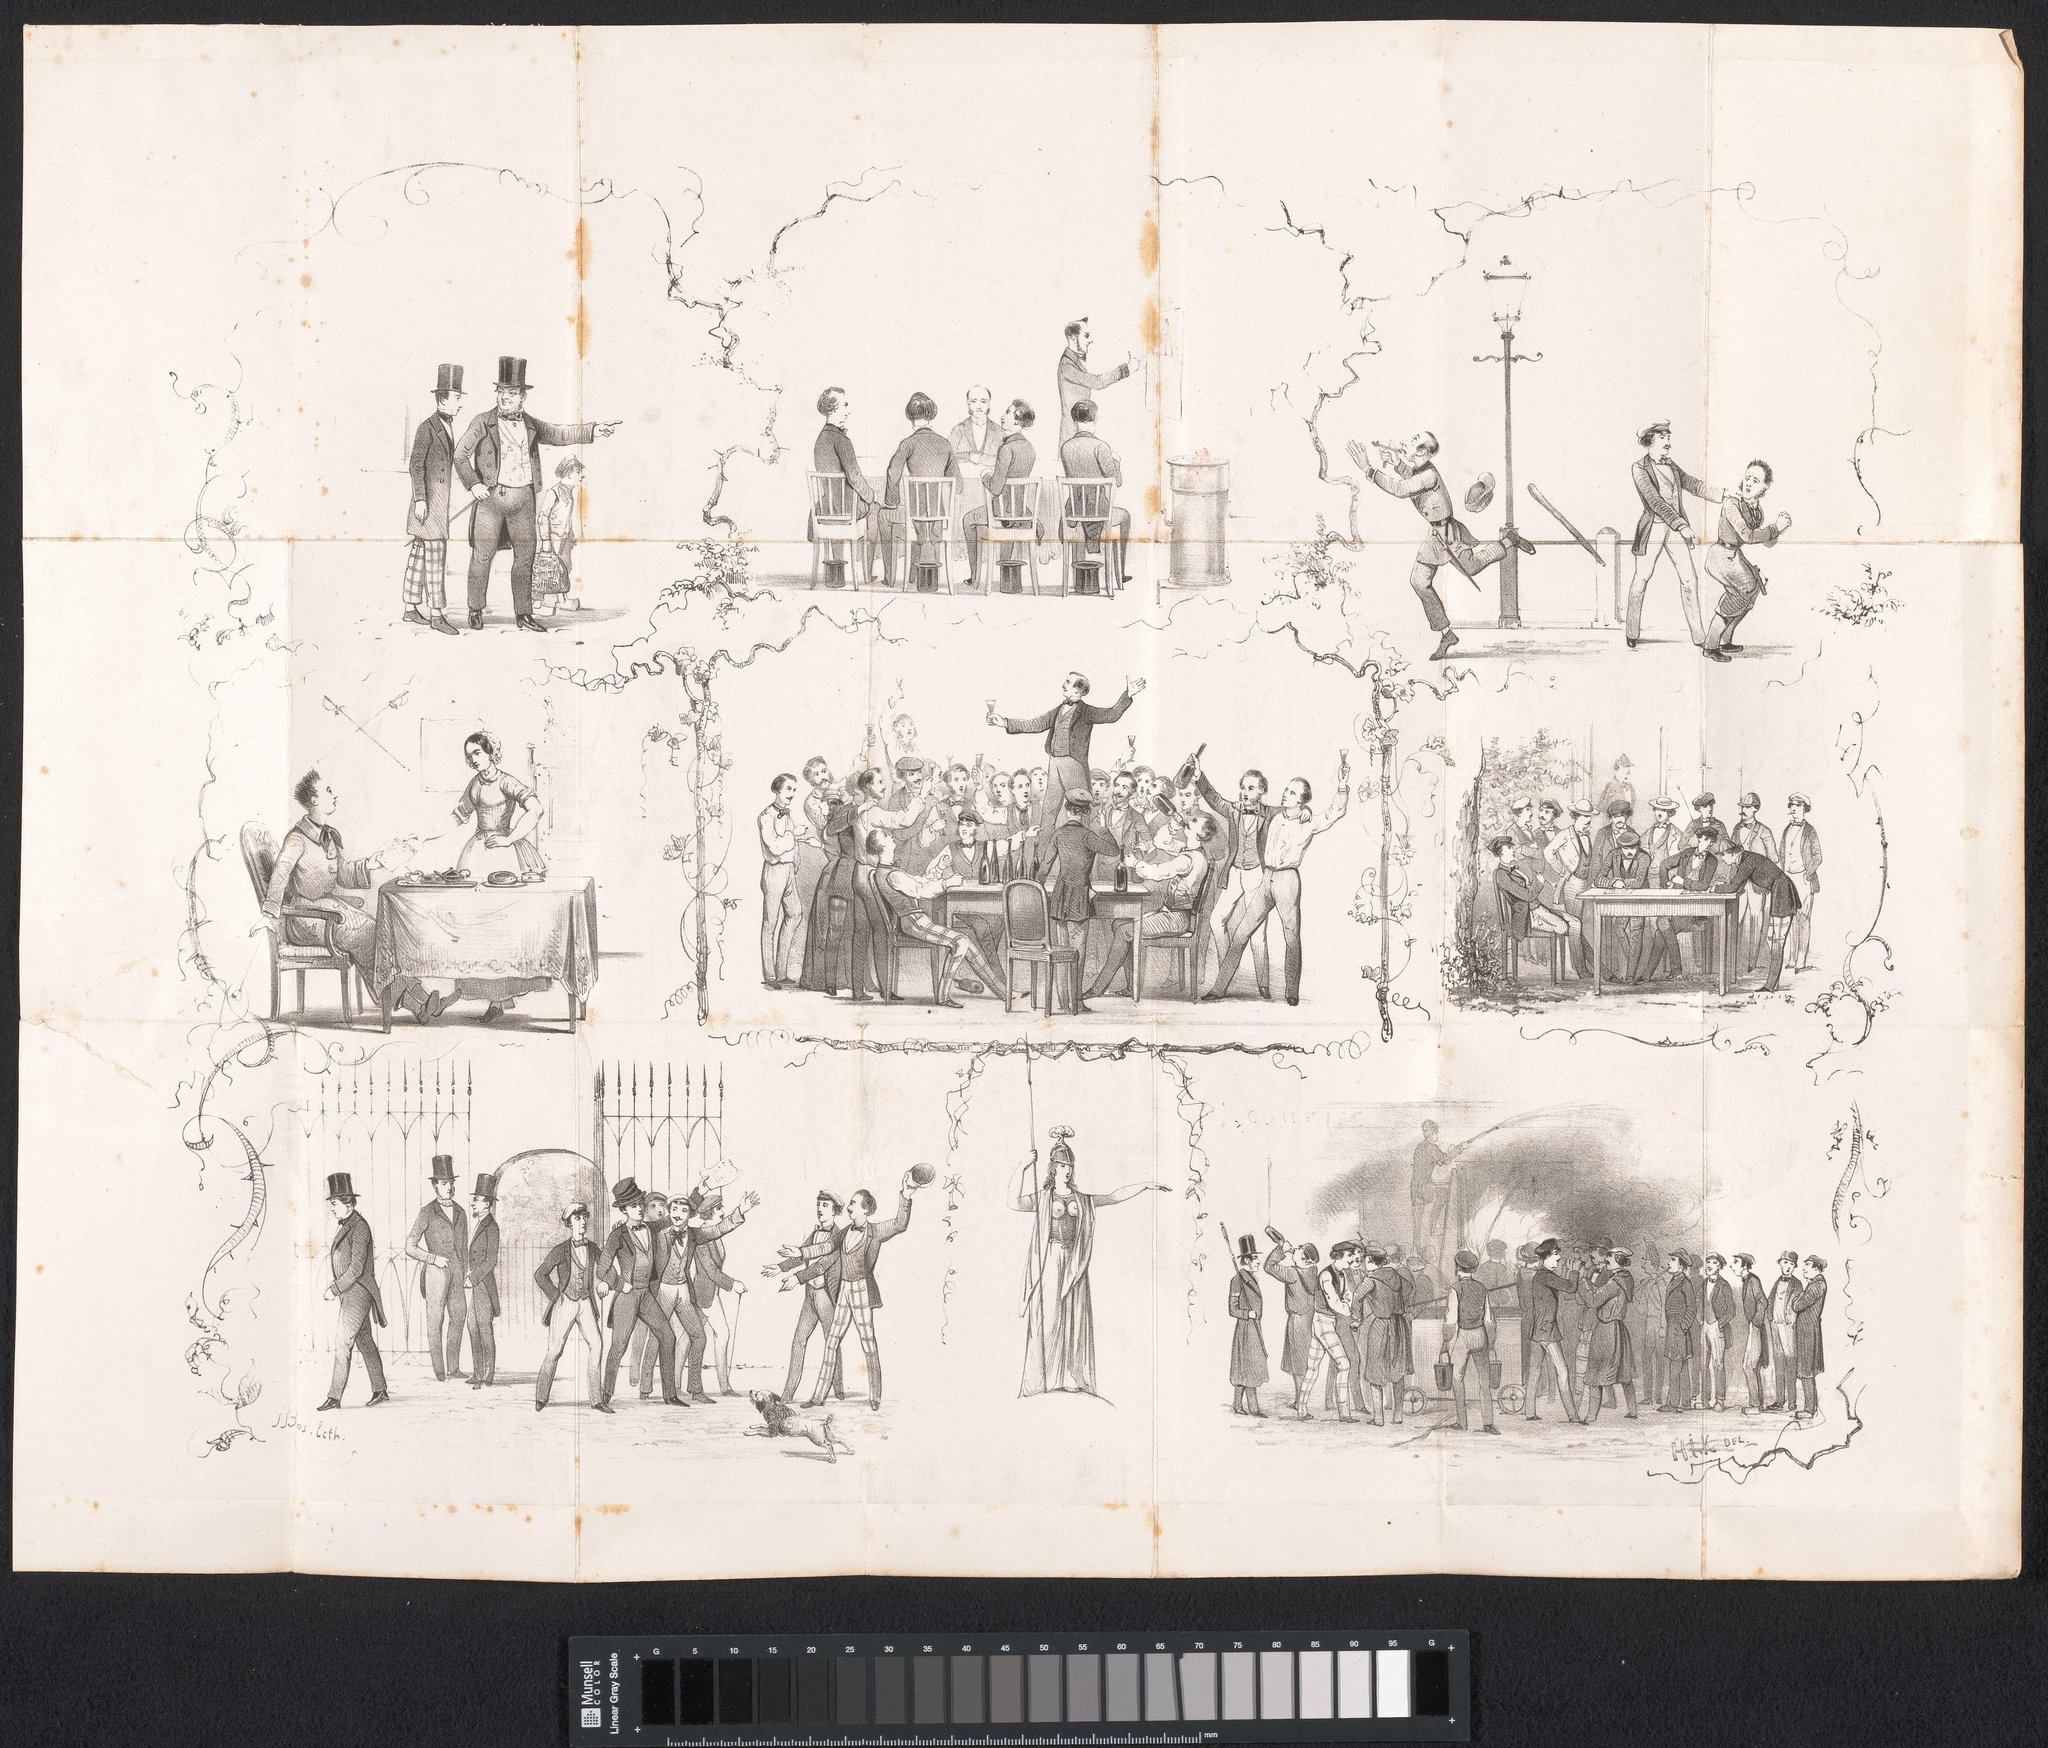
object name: print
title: Spotprent in Leidse studentenalmanak, 1857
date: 1857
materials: paper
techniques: lithograph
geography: leiden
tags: student life, leiden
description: Blad met negen voorstellingen uit het studentenleven. Spotprent in een apart mapje gestoken voorin de studentenalmanak van de Universiteit van Leiden van het jaar 1857.